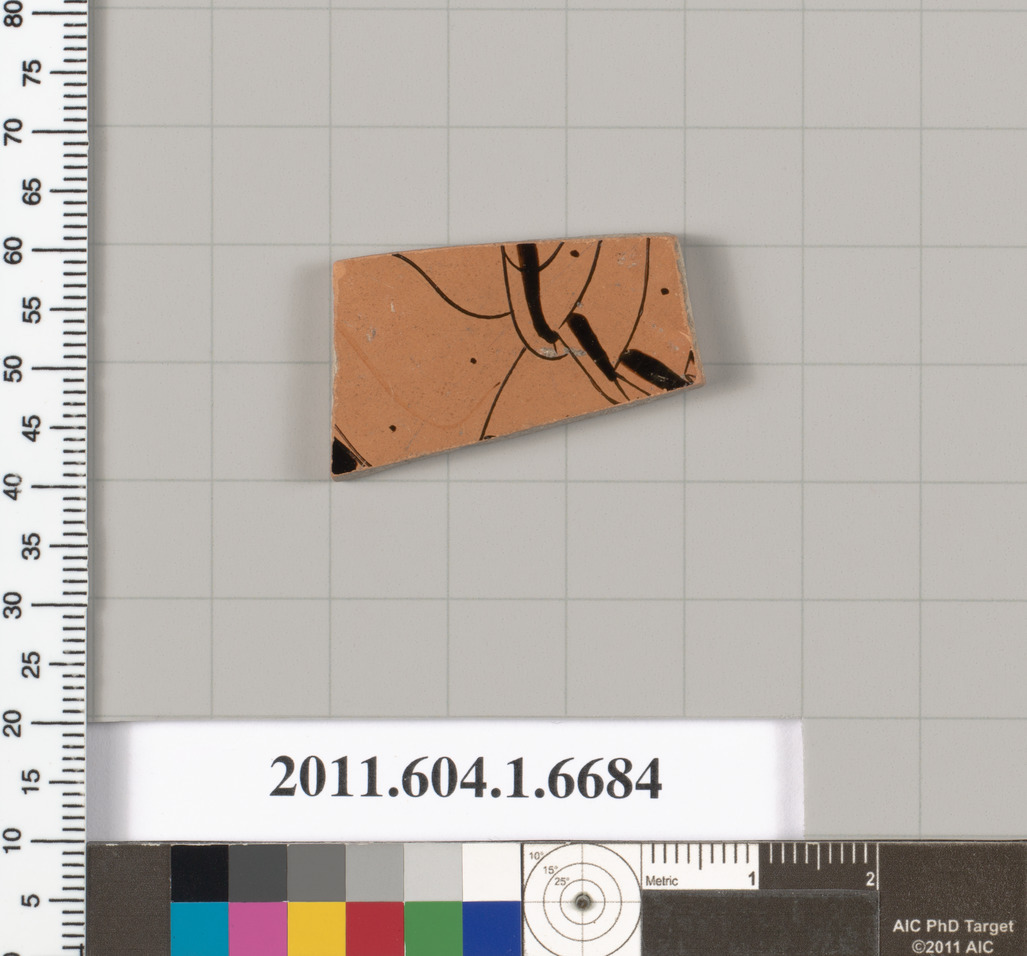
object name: kylix fragment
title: Terracotta fragment of a kylix (drinking cup)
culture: greek, attic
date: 490-470 BCE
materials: terracotta